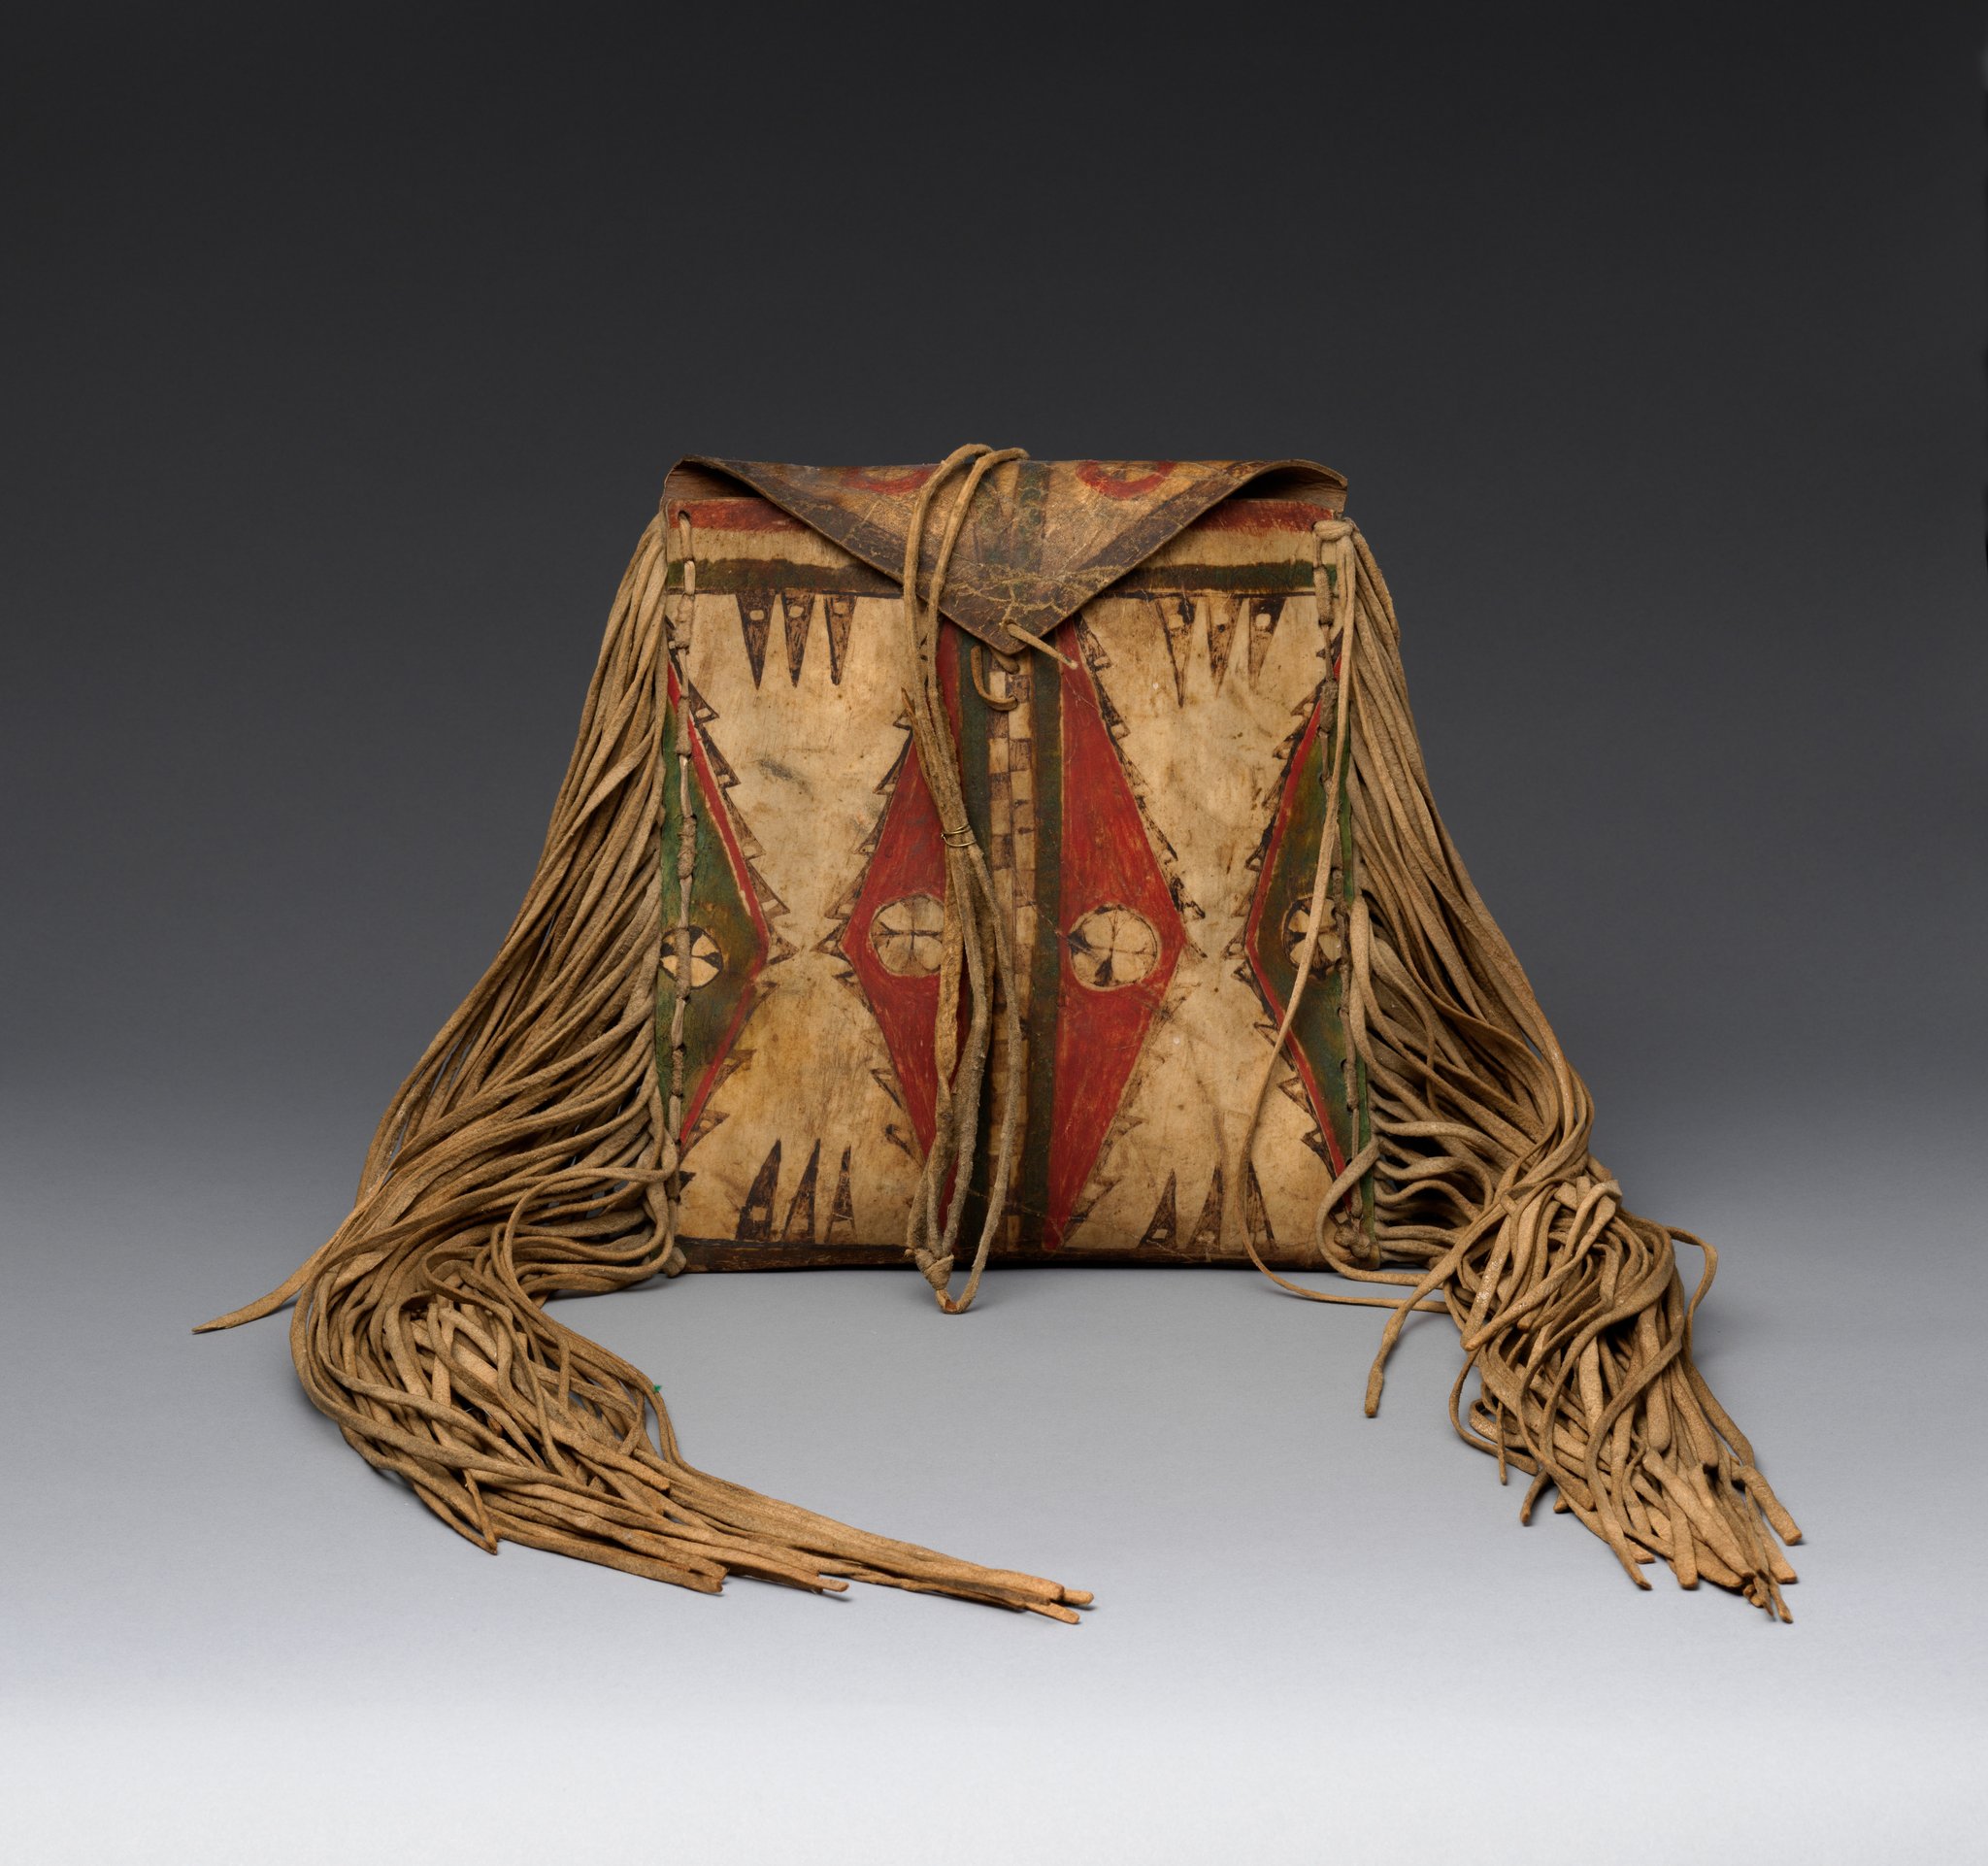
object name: parfleche flat case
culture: comanche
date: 1850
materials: leather, pigment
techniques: tanning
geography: united states